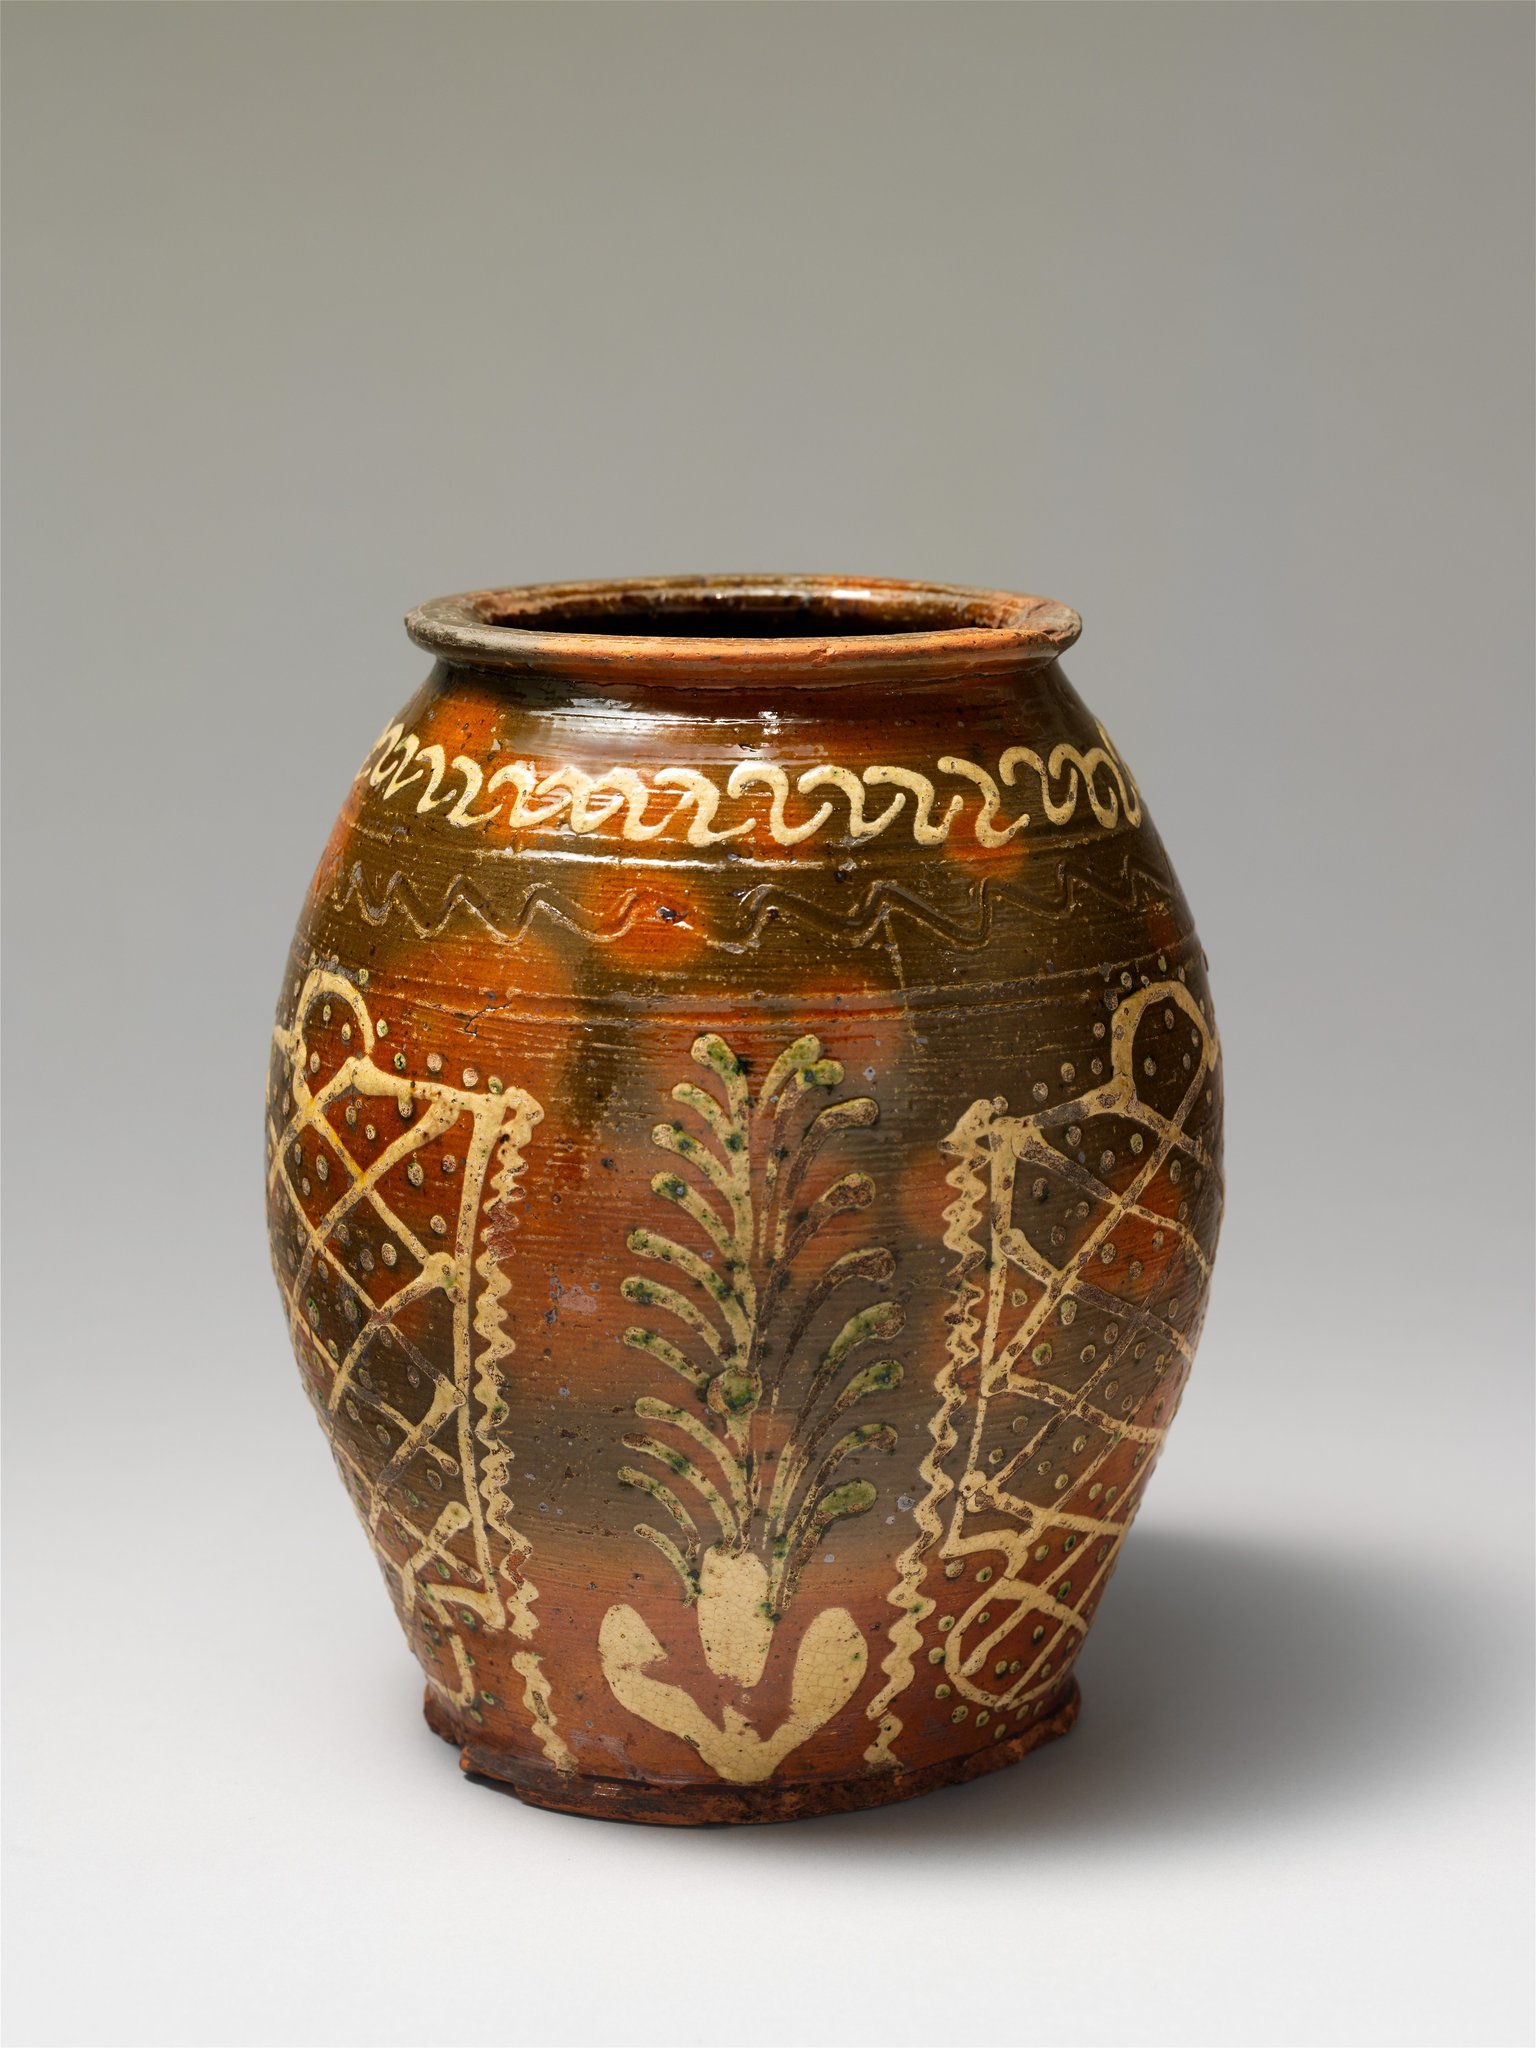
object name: jar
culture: american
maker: christian klinker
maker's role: artist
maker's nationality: american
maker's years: 1773-1798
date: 1773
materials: earthenware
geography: united states